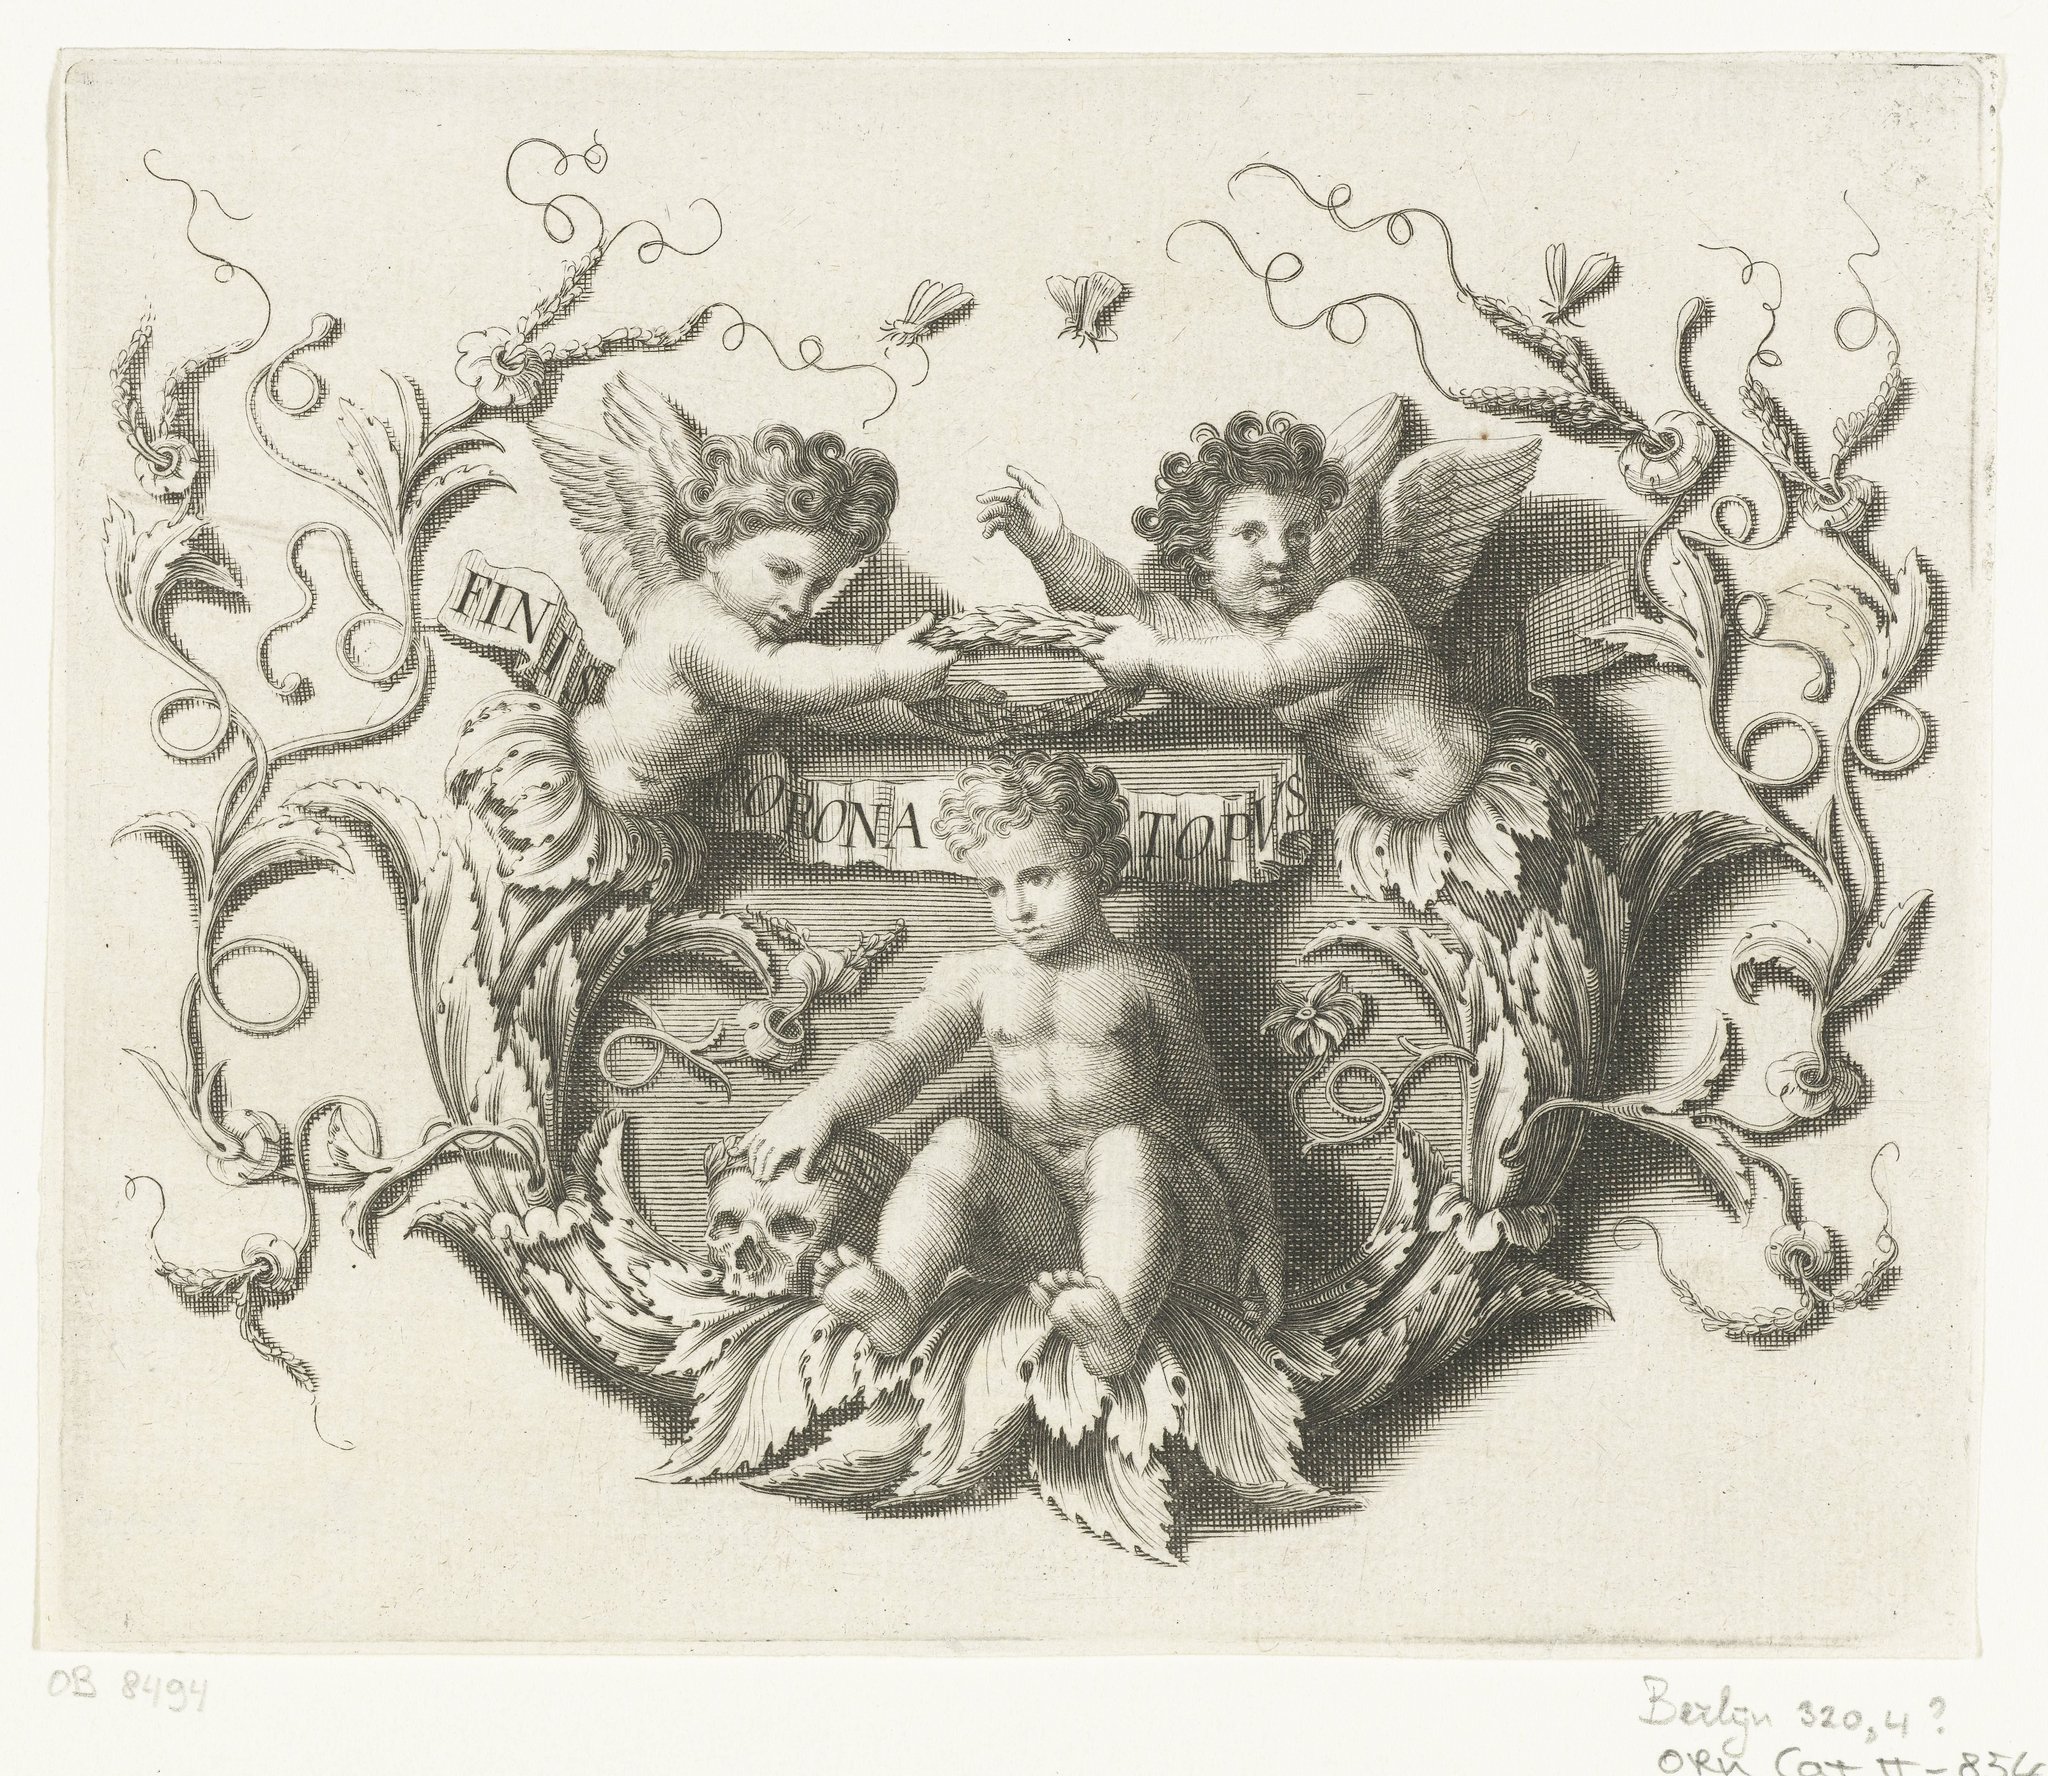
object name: ornament print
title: Finis Corona Topvs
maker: Anonymous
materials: paper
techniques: engraving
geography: paris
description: Vignet. Een cartouche opgebouwd uit bladranken loopt uit in twee putti de een lauwerkrans boven het hoofd van een derde zittende putto houden, wiens hand op een schedel ligt.